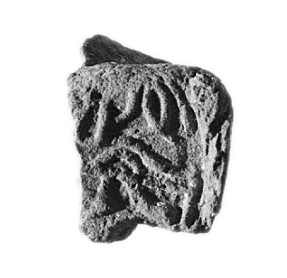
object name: sealing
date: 1981-1640 BCE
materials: mud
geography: egypt